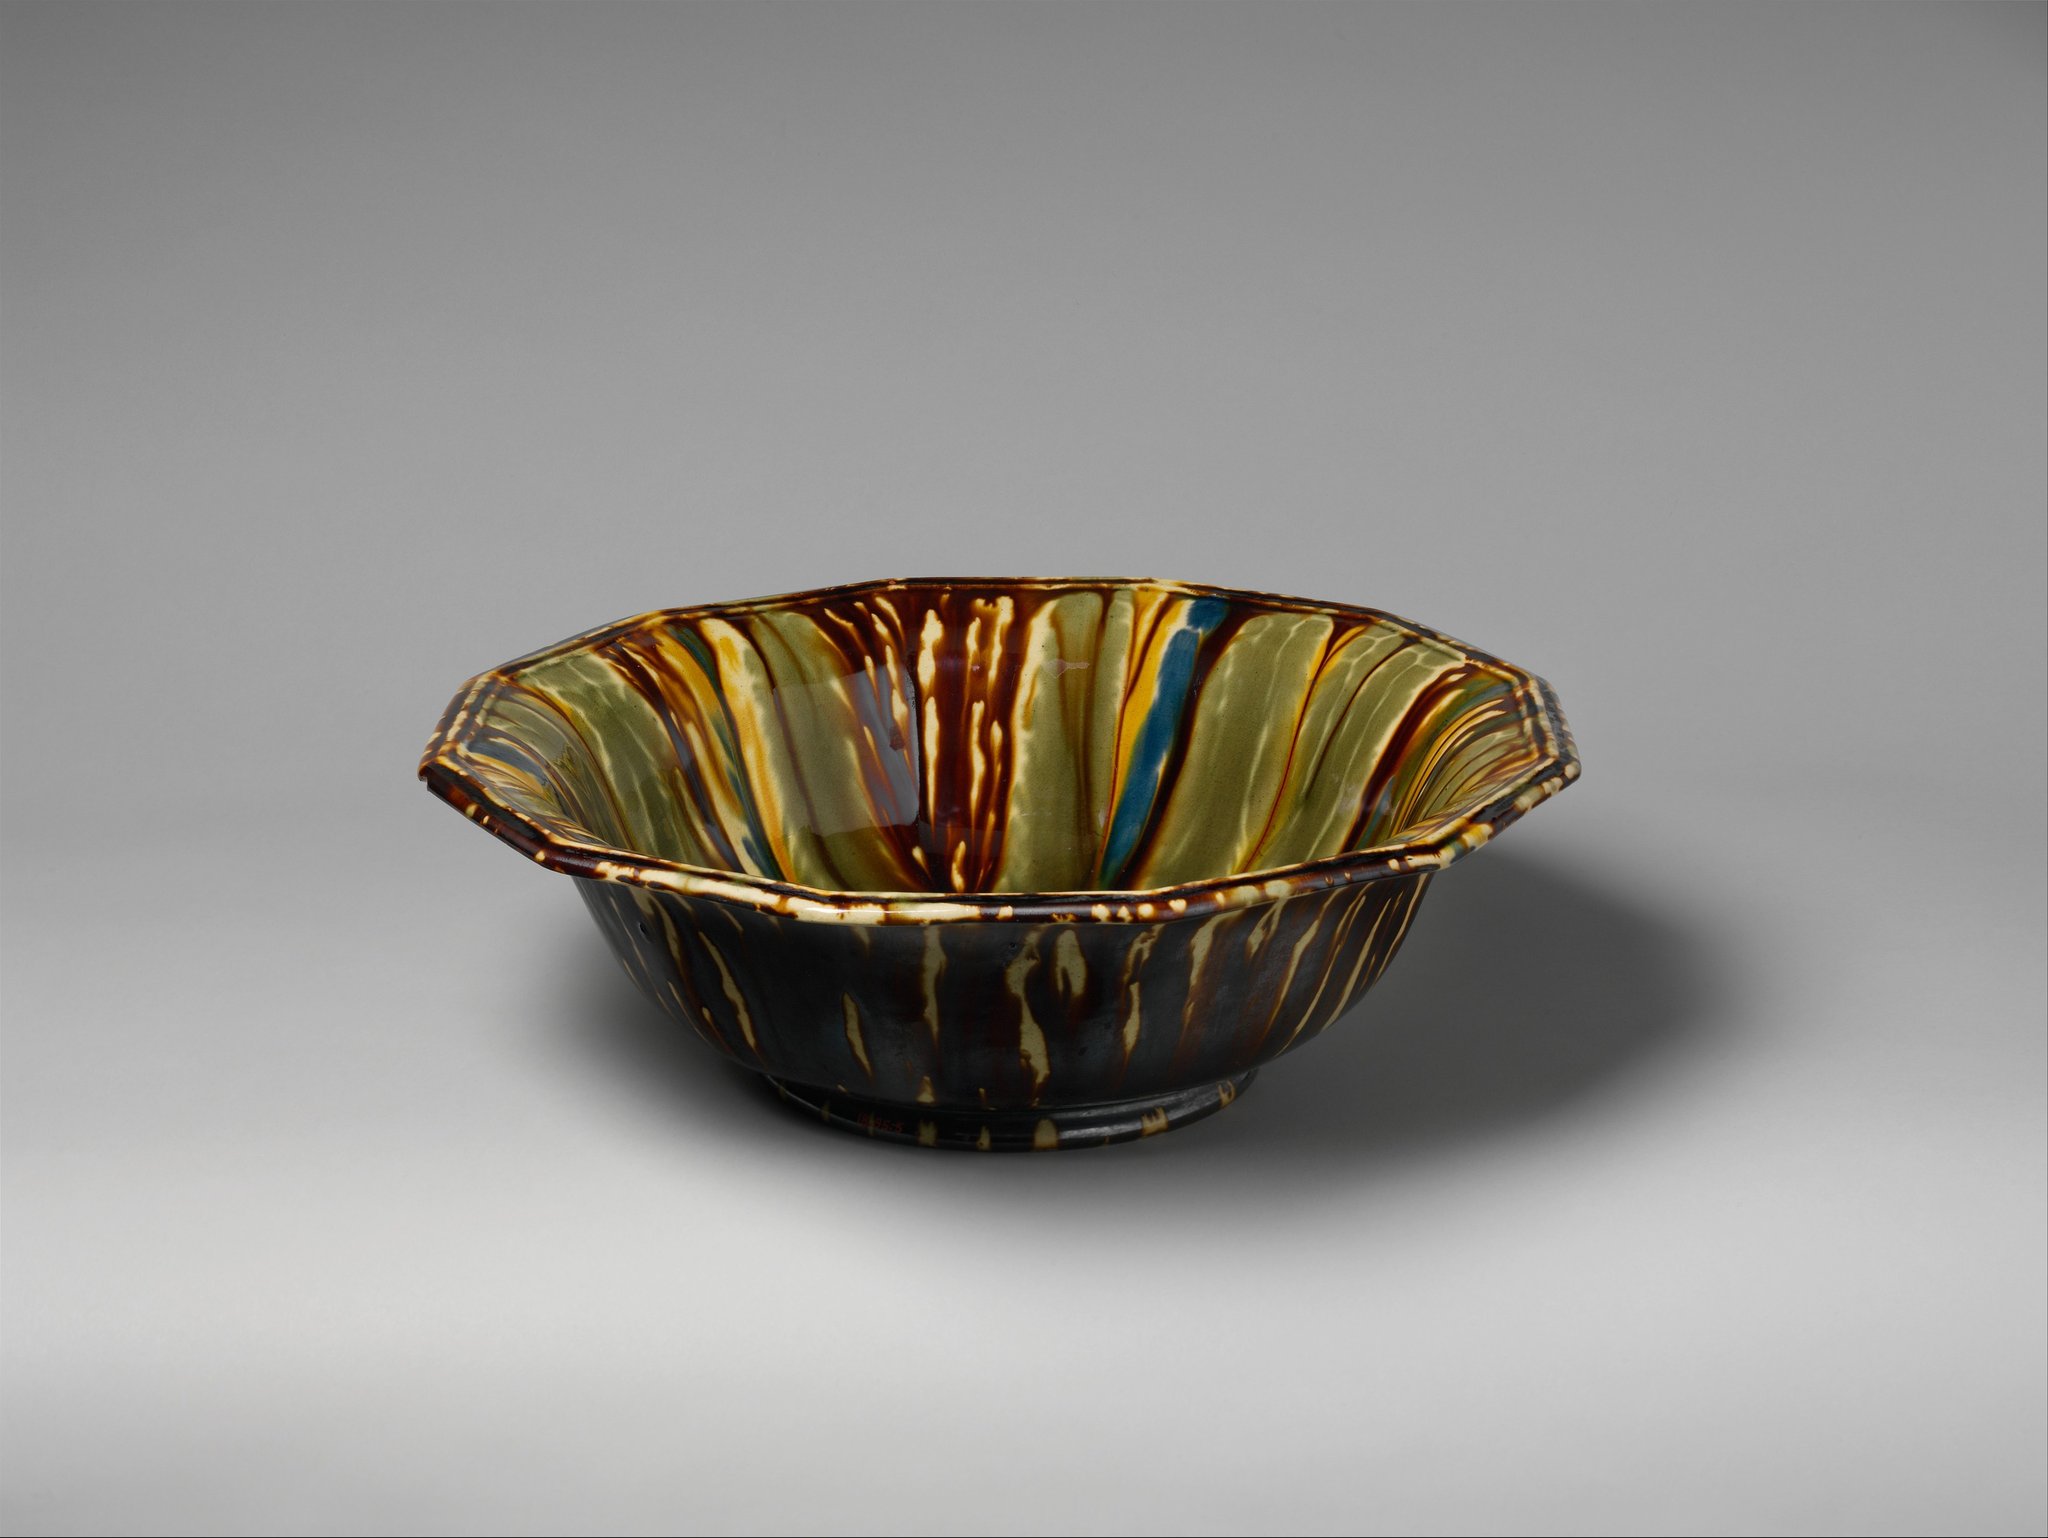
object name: basin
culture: american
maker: lyman, fenton & co.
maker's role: maker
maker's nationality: american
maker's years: 1849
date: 1849-1858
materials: earthenware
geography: united states